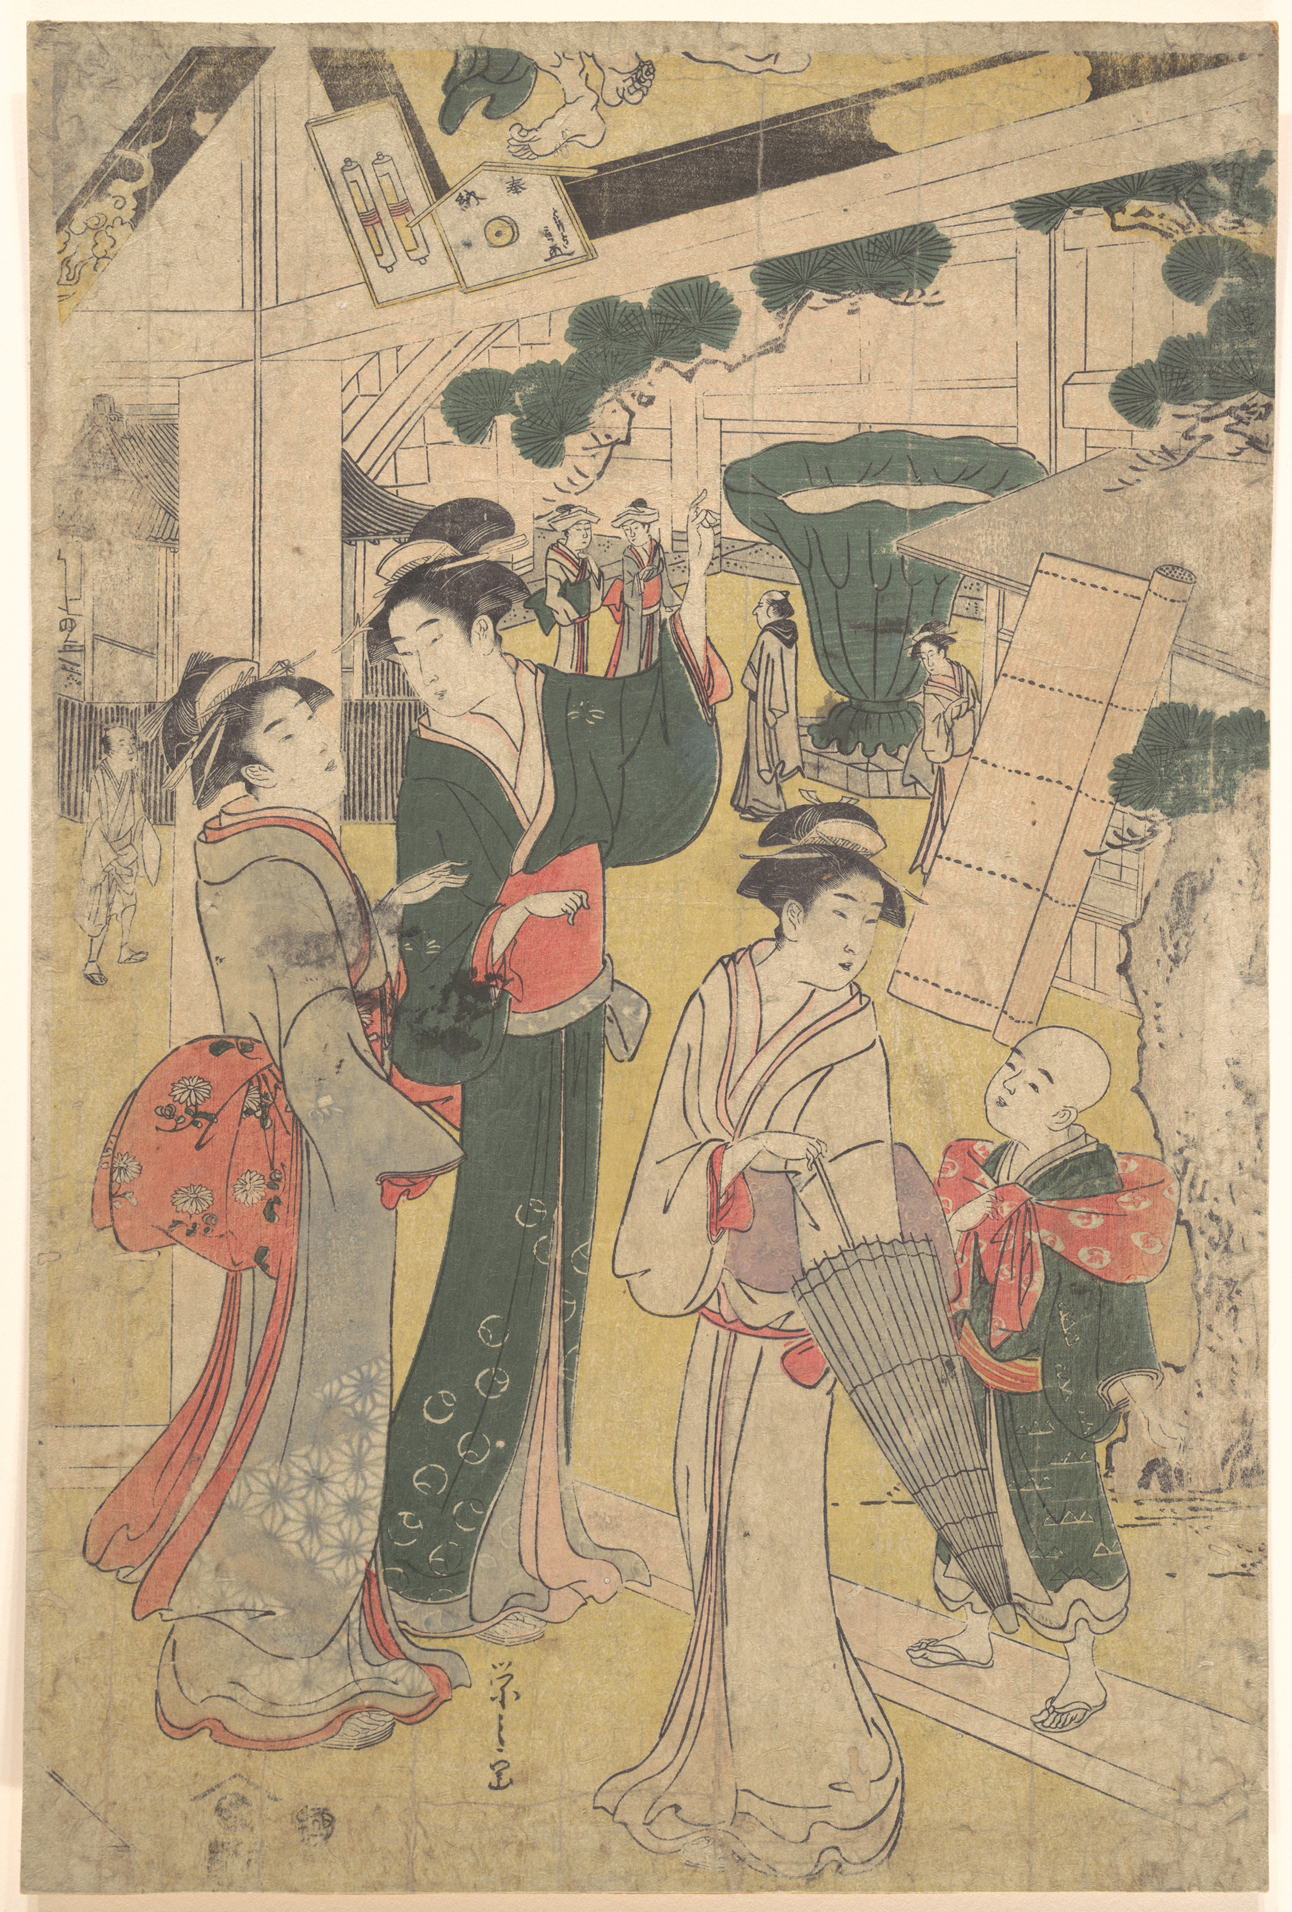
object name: print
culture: japanese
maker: chōbunsai eishi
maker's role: artist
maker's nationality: japanese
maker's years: 1756-1829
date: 1756-1829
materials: ink, paper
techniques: woodblock print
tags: boys,men,women